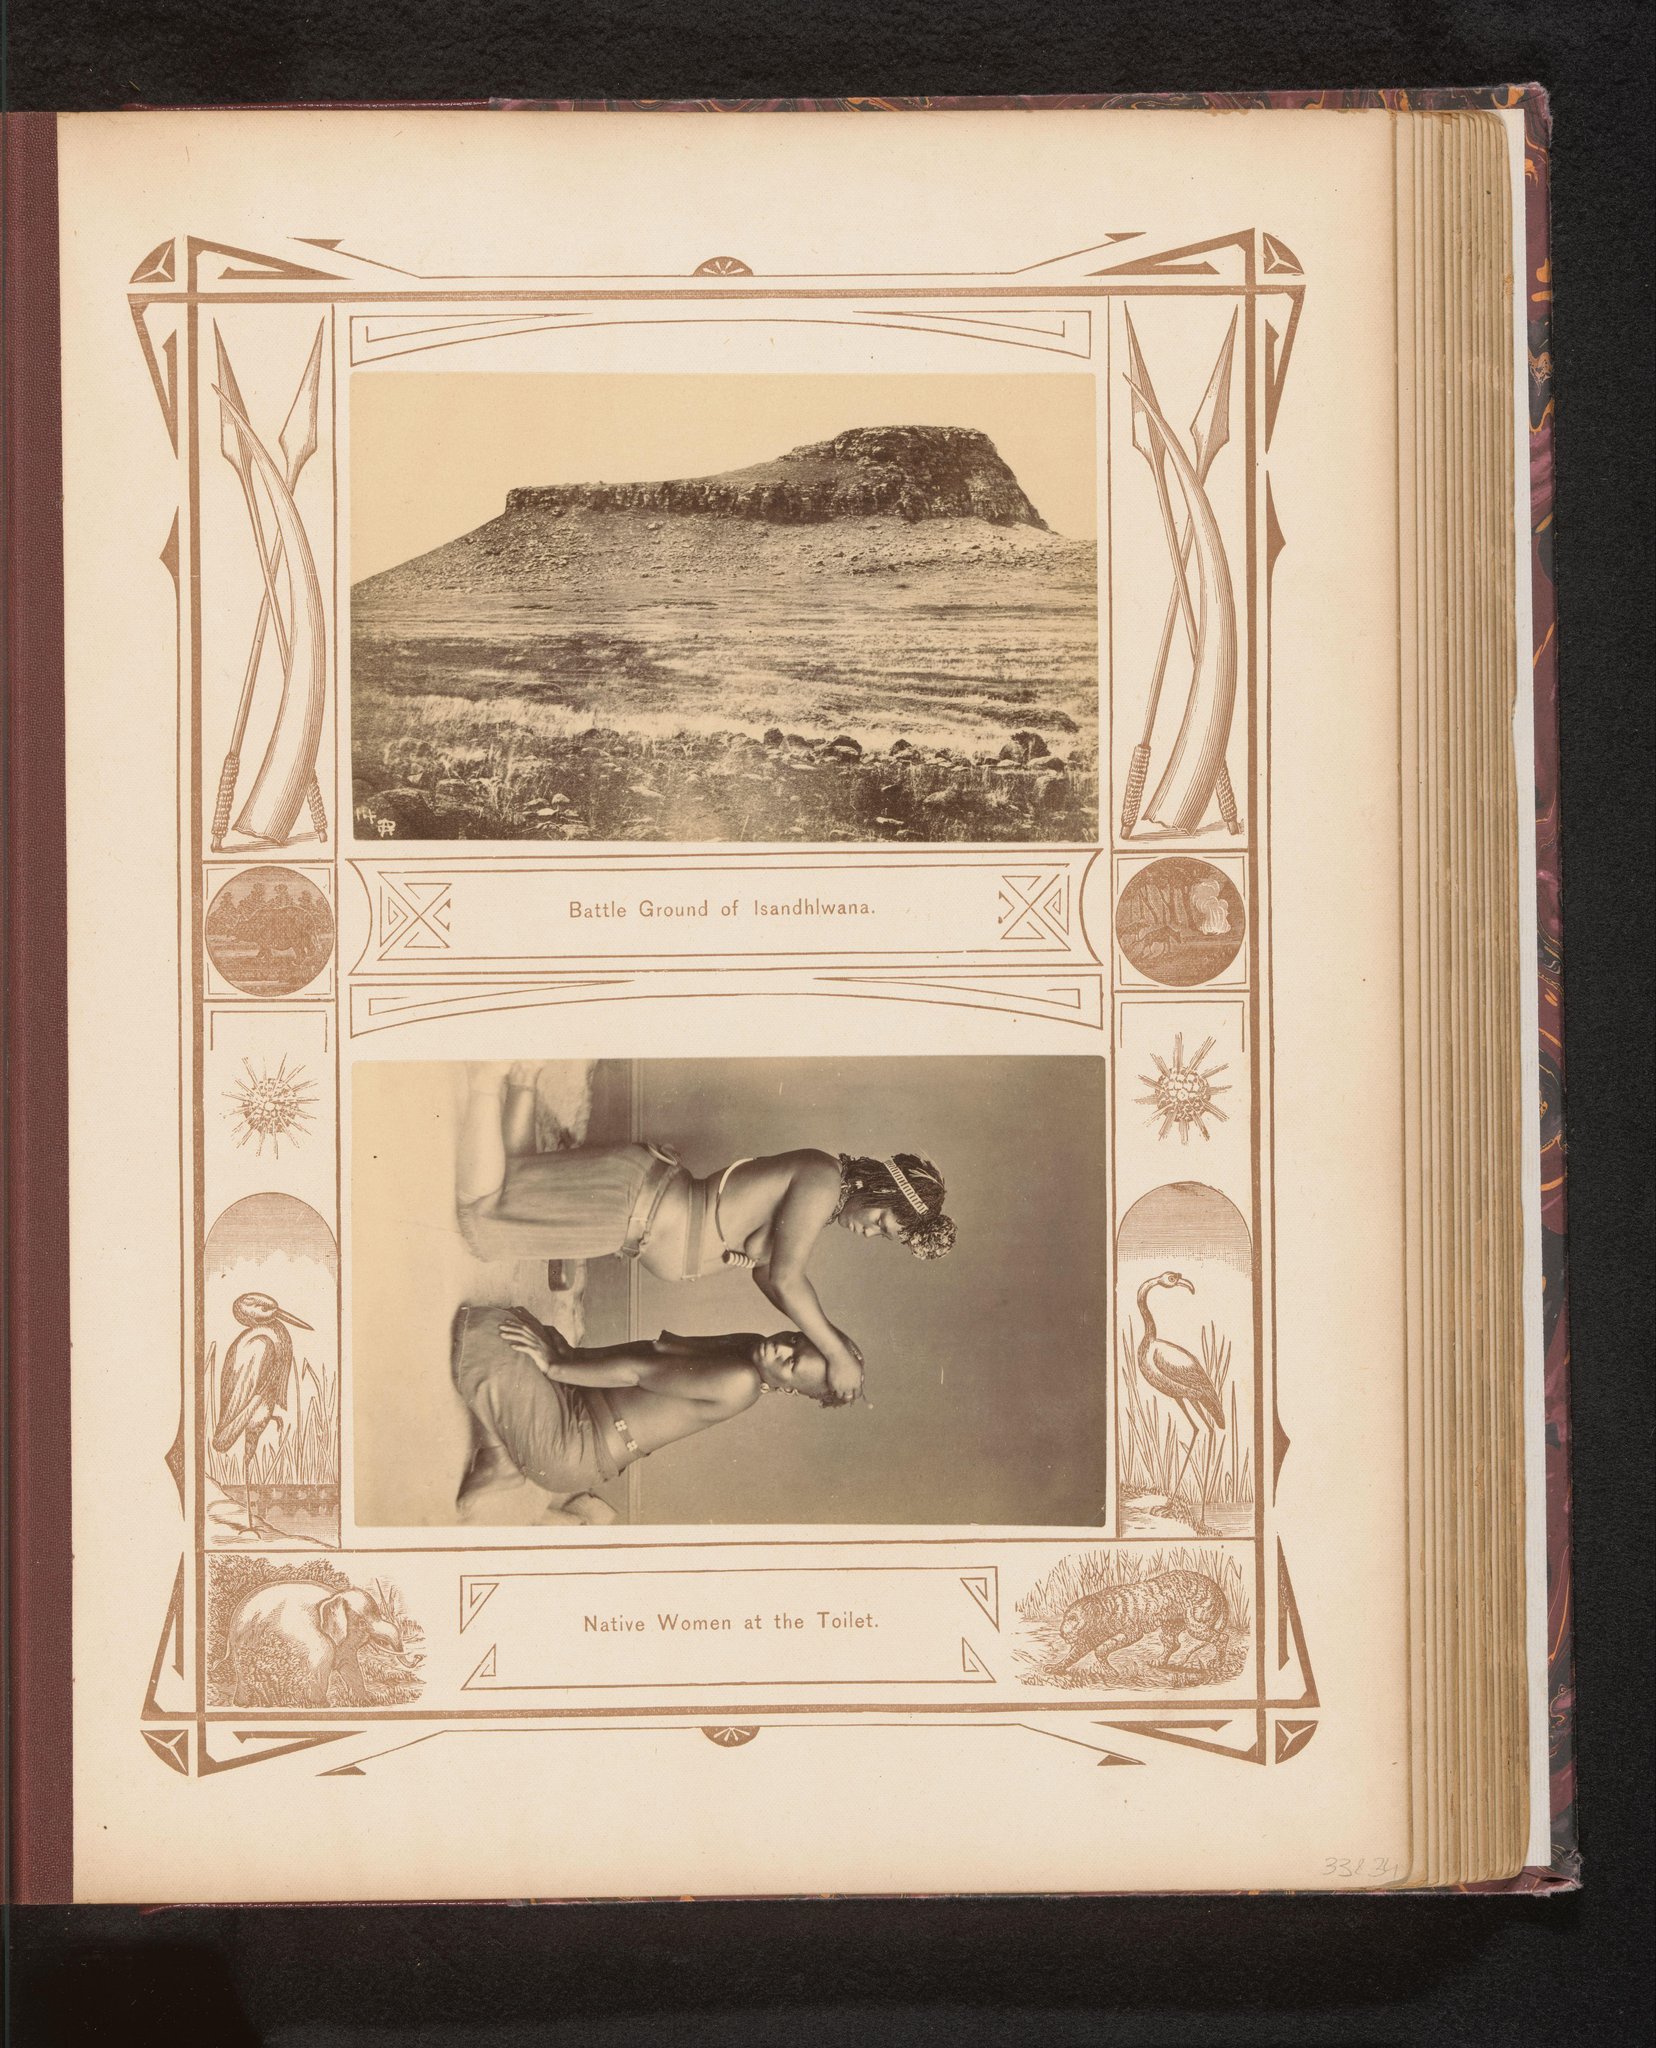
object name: photograph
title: Native women at the toilet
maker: Anonymous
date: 1877-1882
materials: photographic support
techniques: albumen print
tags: adult woman, africans, historical persons, hairdress